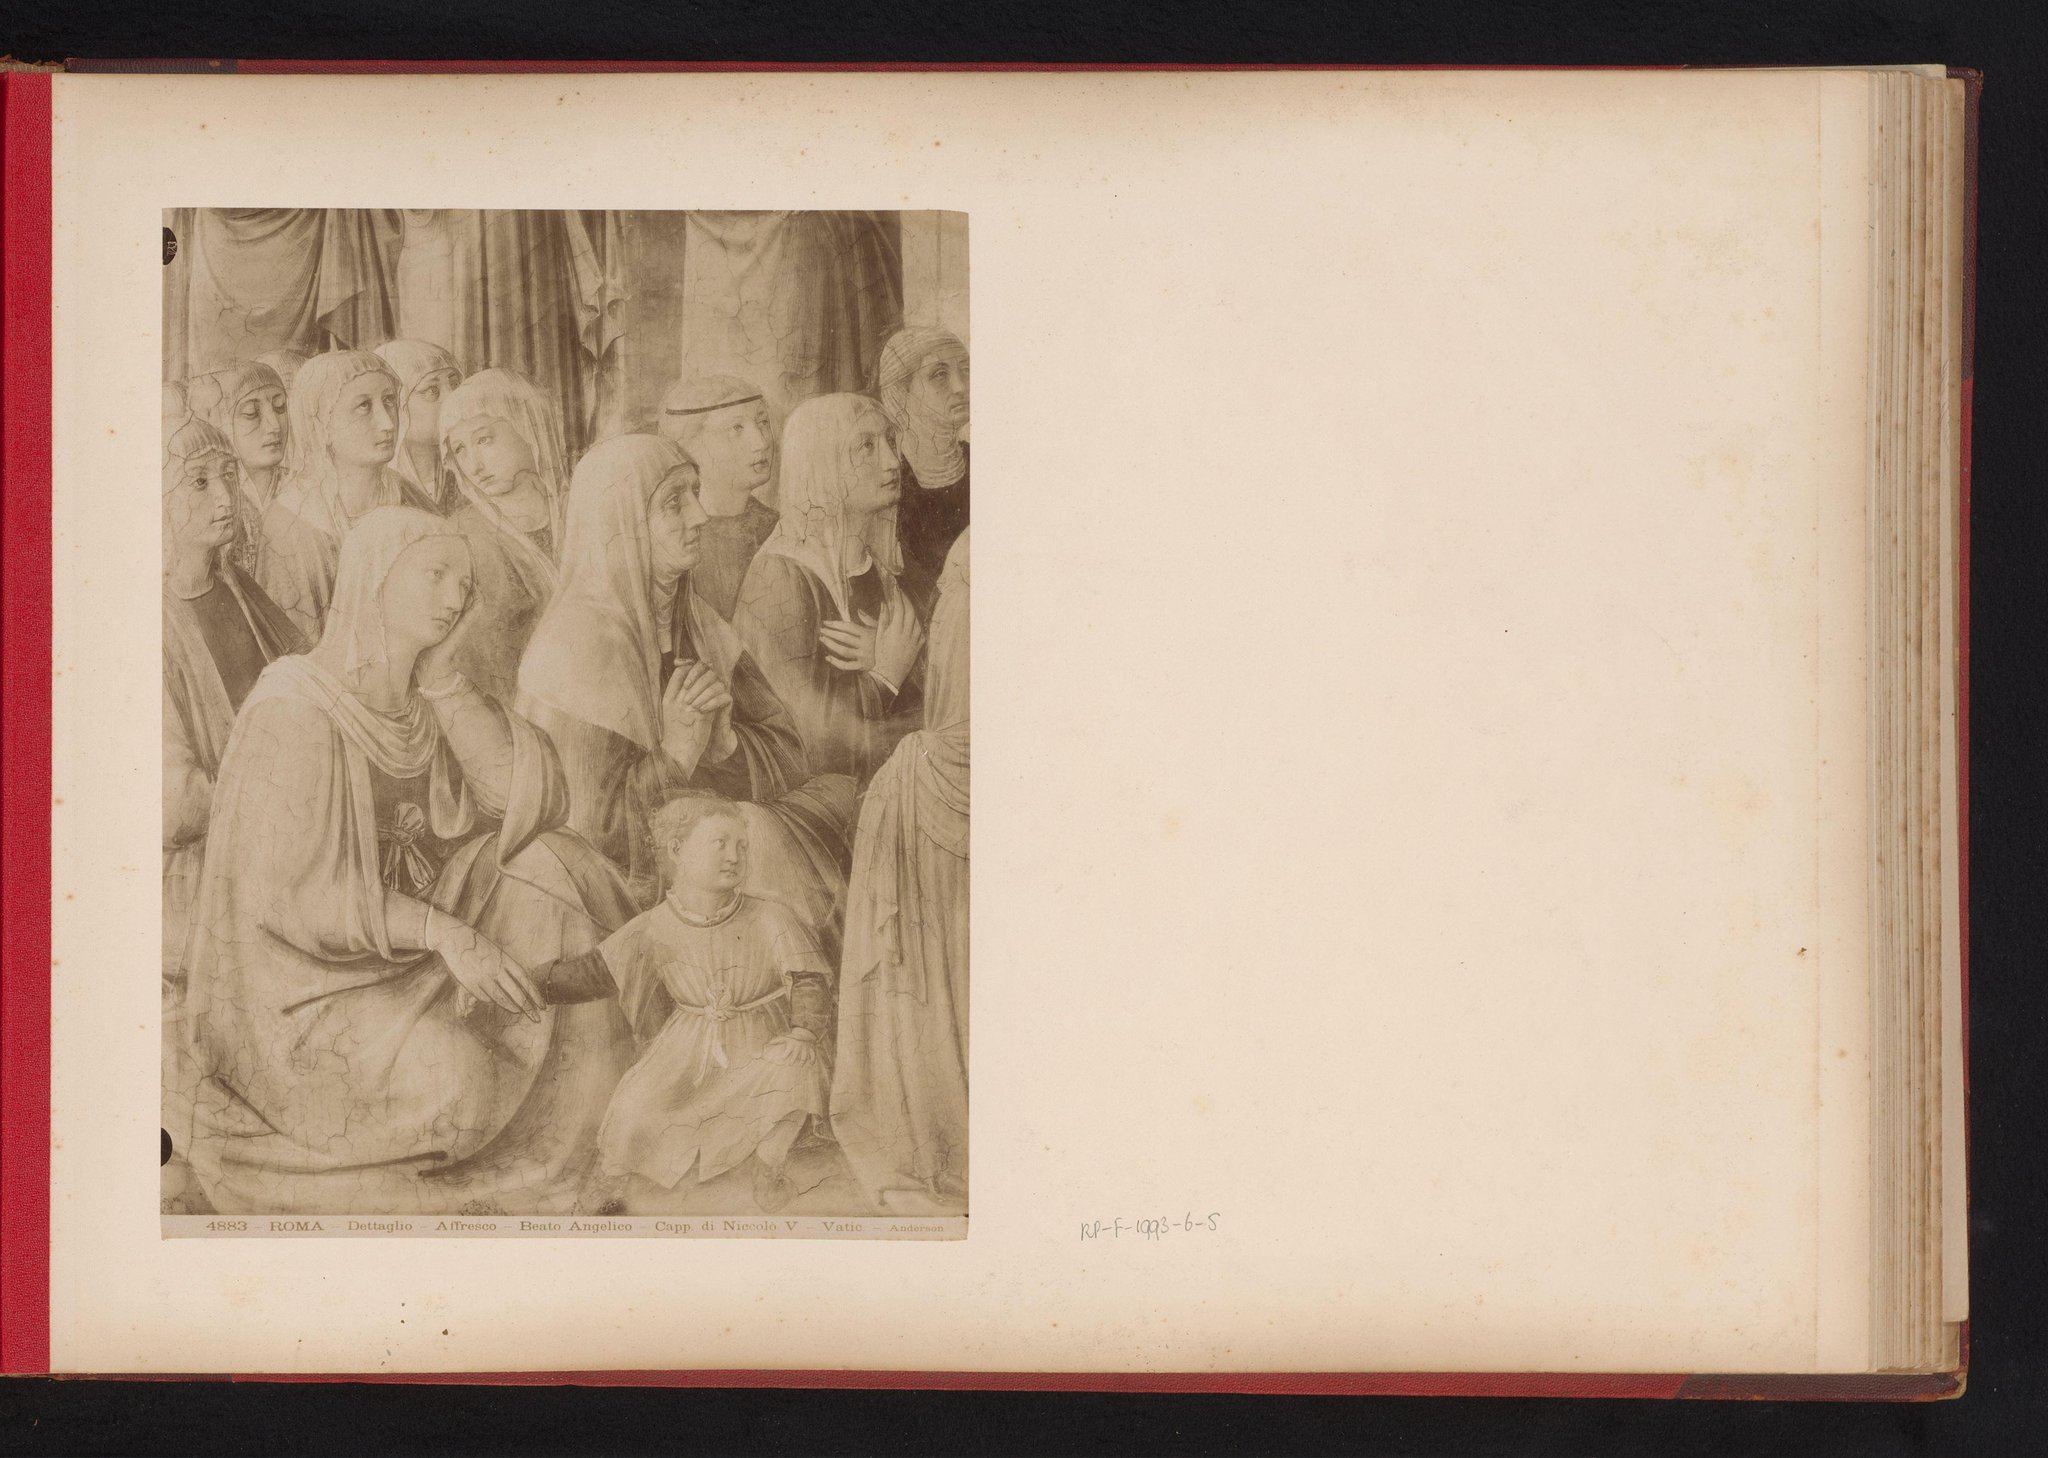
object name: photograph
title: Fotoreproductie van een detail van fresco Prediking van de heilige Stefanus, door Fra Angelico, Kapel van Nicolaas V, Vaticaan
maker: james anderson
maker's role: fotograaf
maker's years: 1813-1877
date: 1857-1875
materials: paper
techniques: albumen print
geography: chapel of nicholas v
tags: the deacon and (proto)martyr stephen; possible attributes: censer, stones, picture, painting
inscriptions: inscription: ‘4883 - ROMA - Dettaglio - Affresco - Beato Angelico - Capp. di Niccolò V - Vatic. - Anderson’